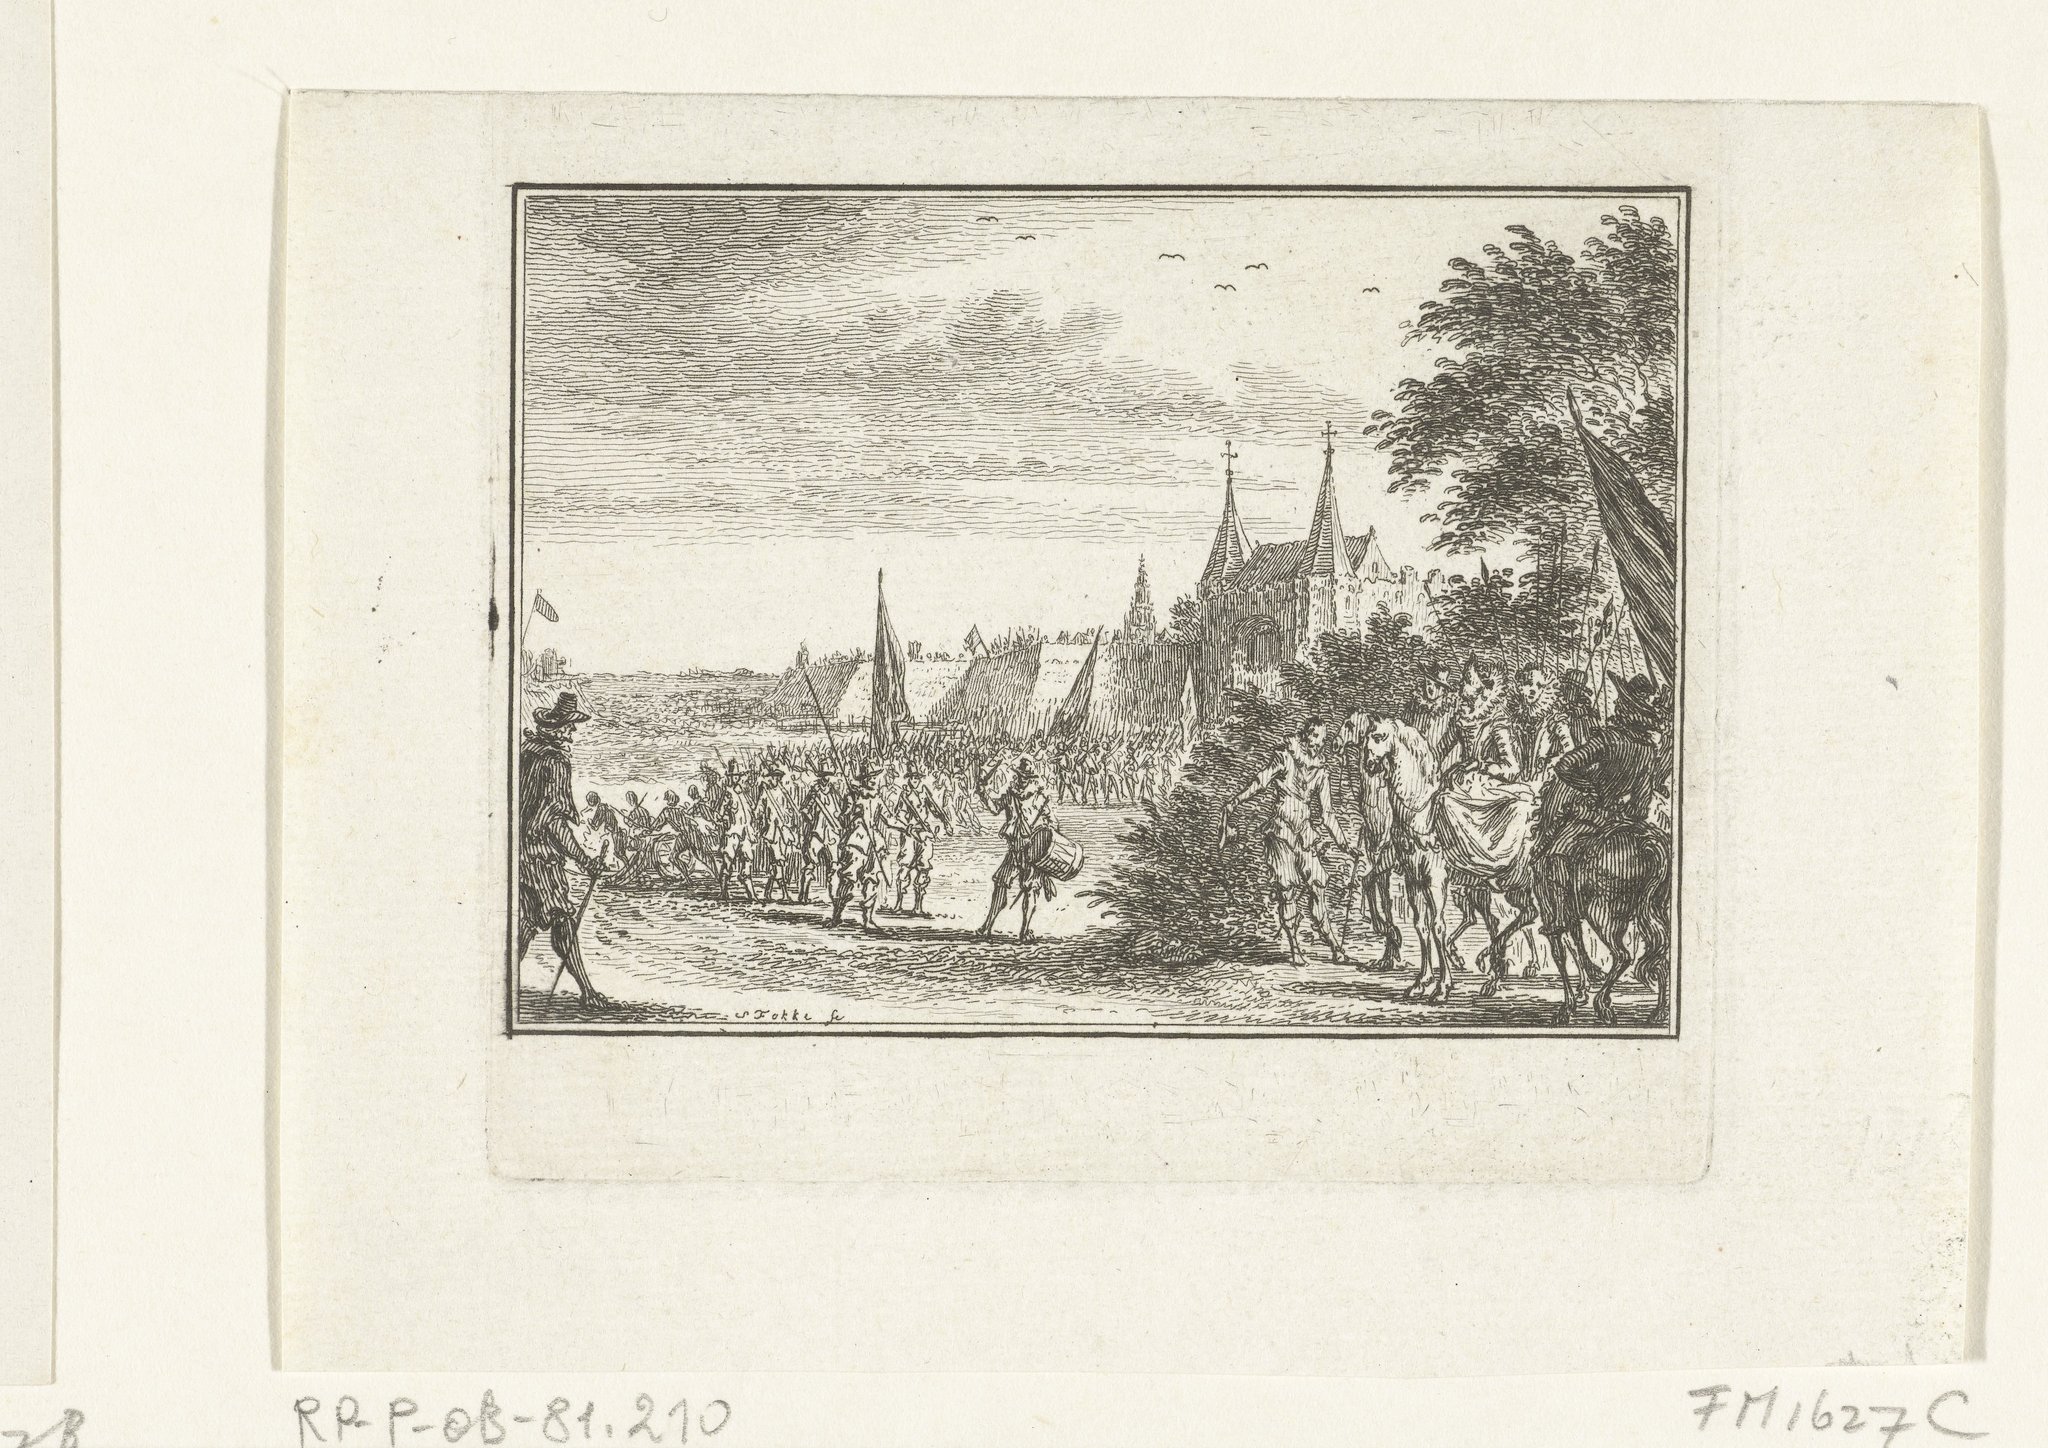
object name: print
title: Spaanse troepen verlaten Den Bosch, 1629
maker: simon fokke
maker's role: draughtsman, print maker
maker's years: 1712-1784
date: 1782-1784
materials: paper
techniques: etching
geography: northern netherlands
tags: delft, the hague, frederick henry (prince of orange), capture of city (after the siege), den bosch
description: Gebruikt als illustratie in: J.W. te Water, De vaderlandsche Historie van den heere J. Wagenaar, verkort, en met leerzaame aanmerkingen, ten dienste der Nederlandsche jeugd, 1784-1800, 4 delen. Dit nummer is een door het RPK toegevoegd nummer en staat niet in Frederik Muller, het werk waar de prent voor is gemaakt of uit afkomstig is, staat wel vermeld in Frederik Muller.